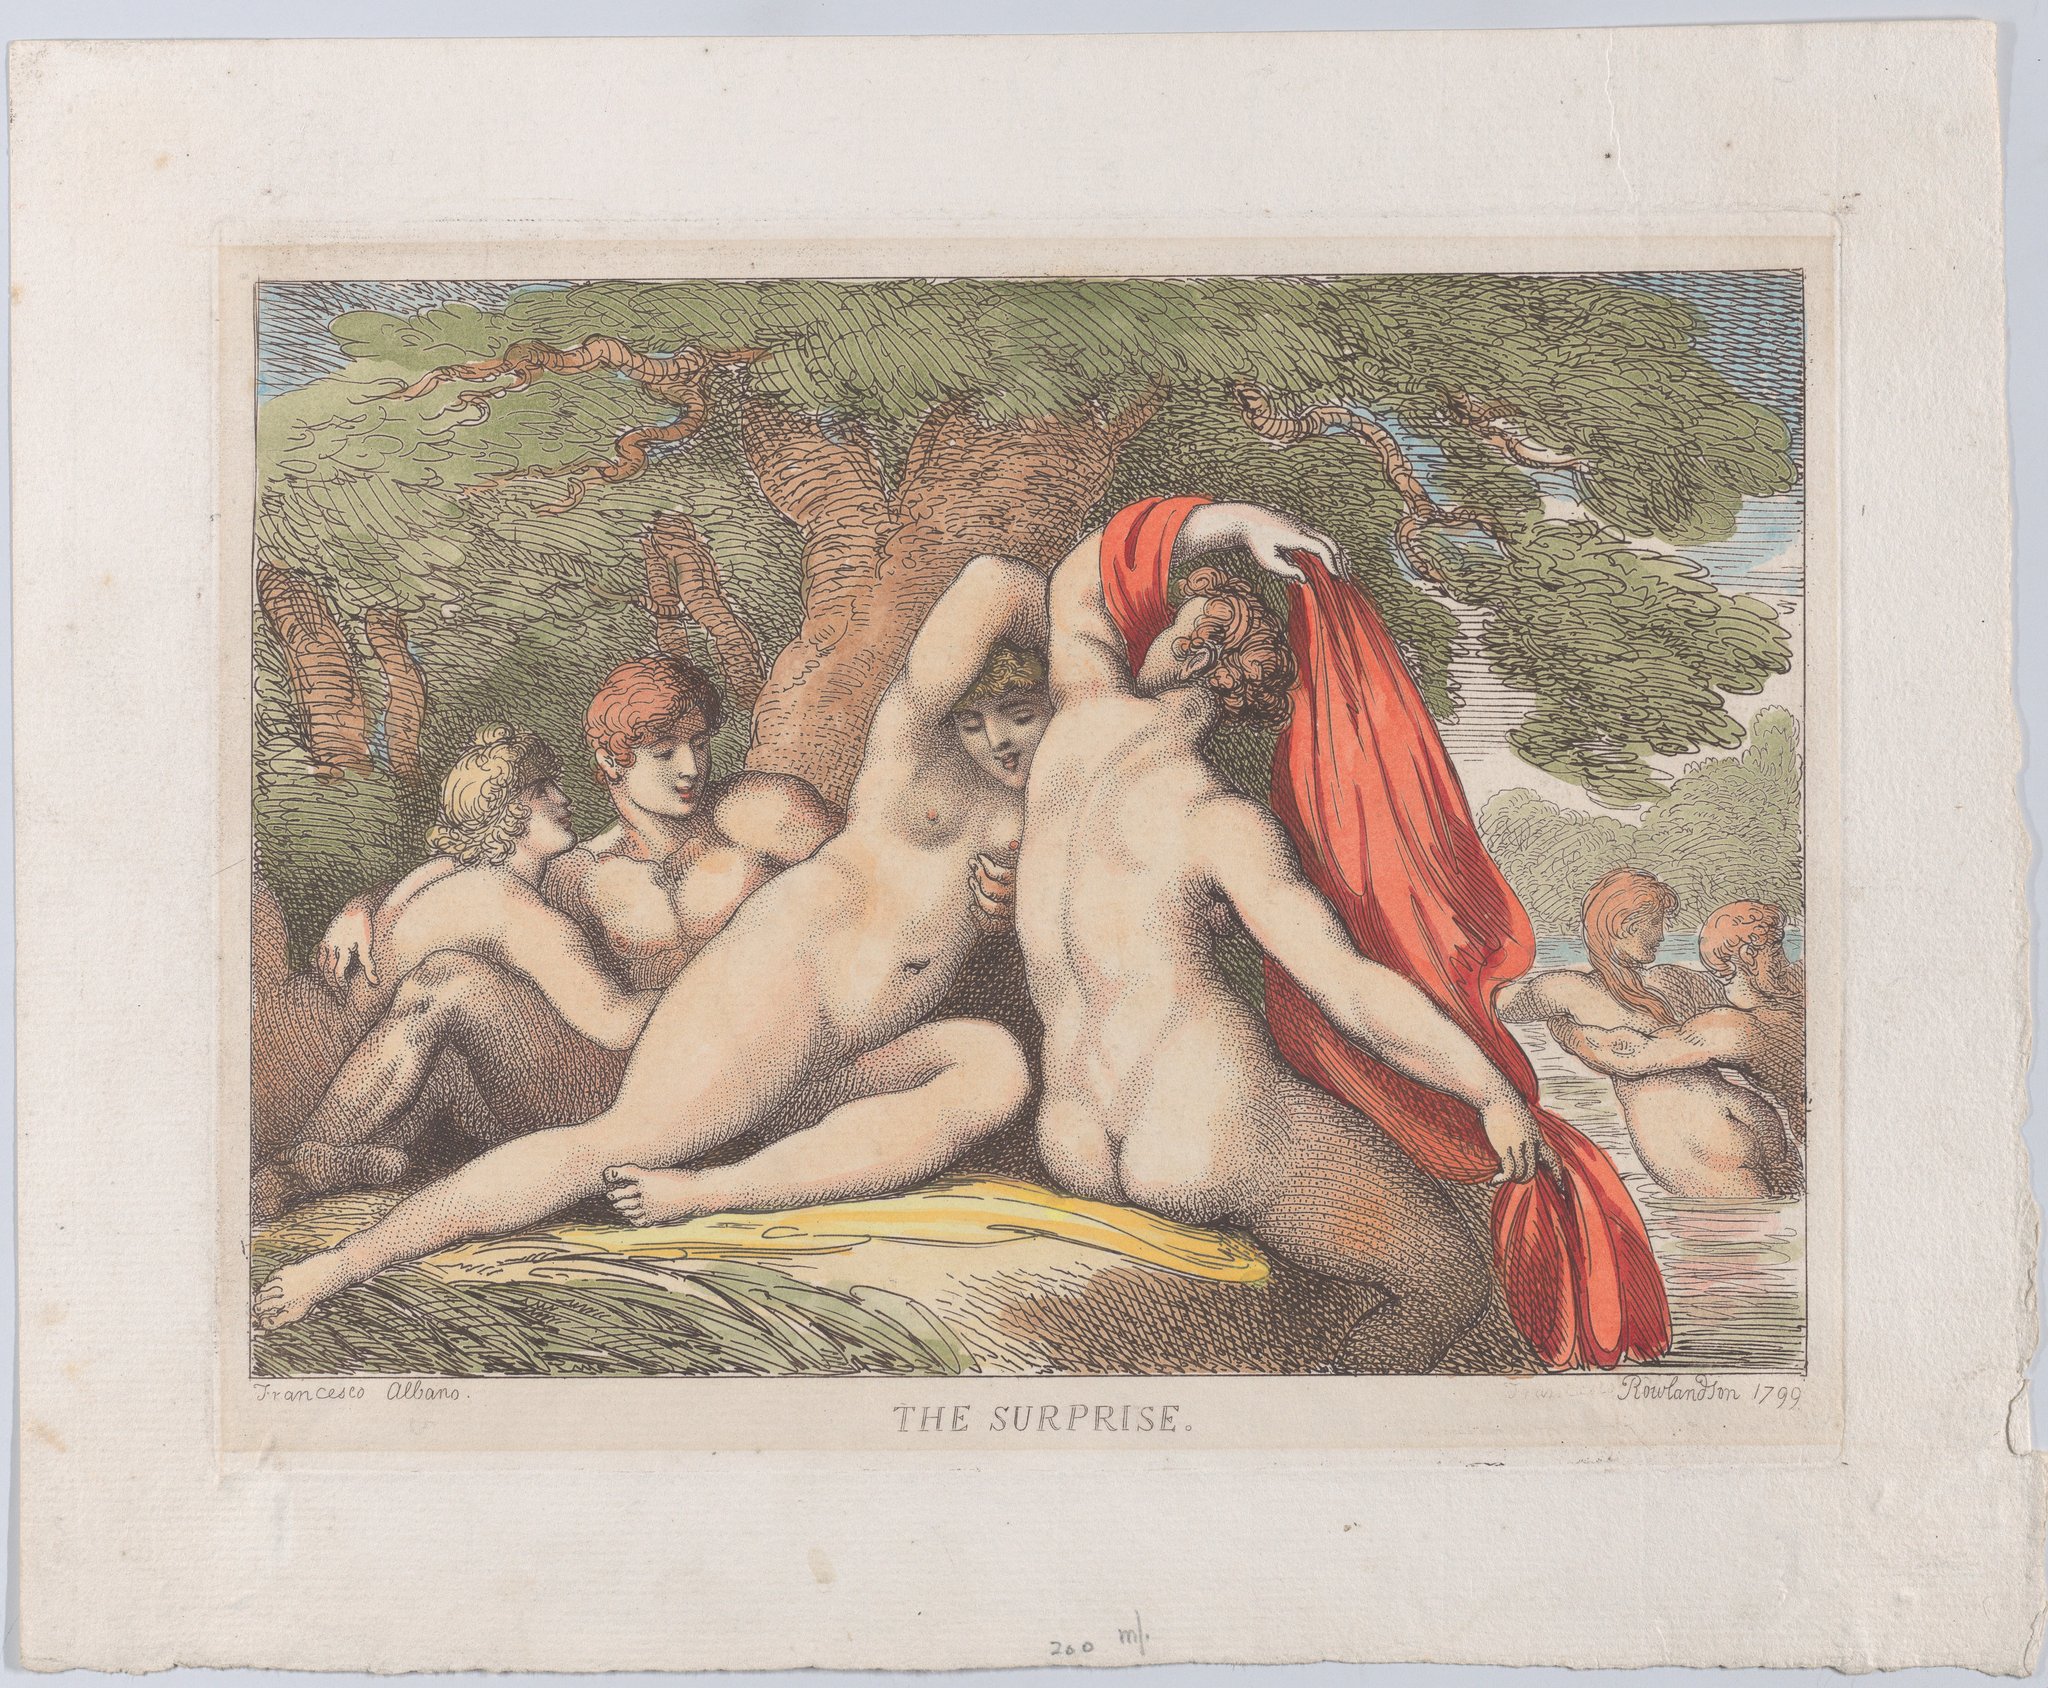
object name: print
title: The Surprise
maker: thomas rowlandson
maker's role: artist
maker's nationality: british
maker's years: 1757-1827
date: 1799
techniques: etching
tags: male nudes,female nudes